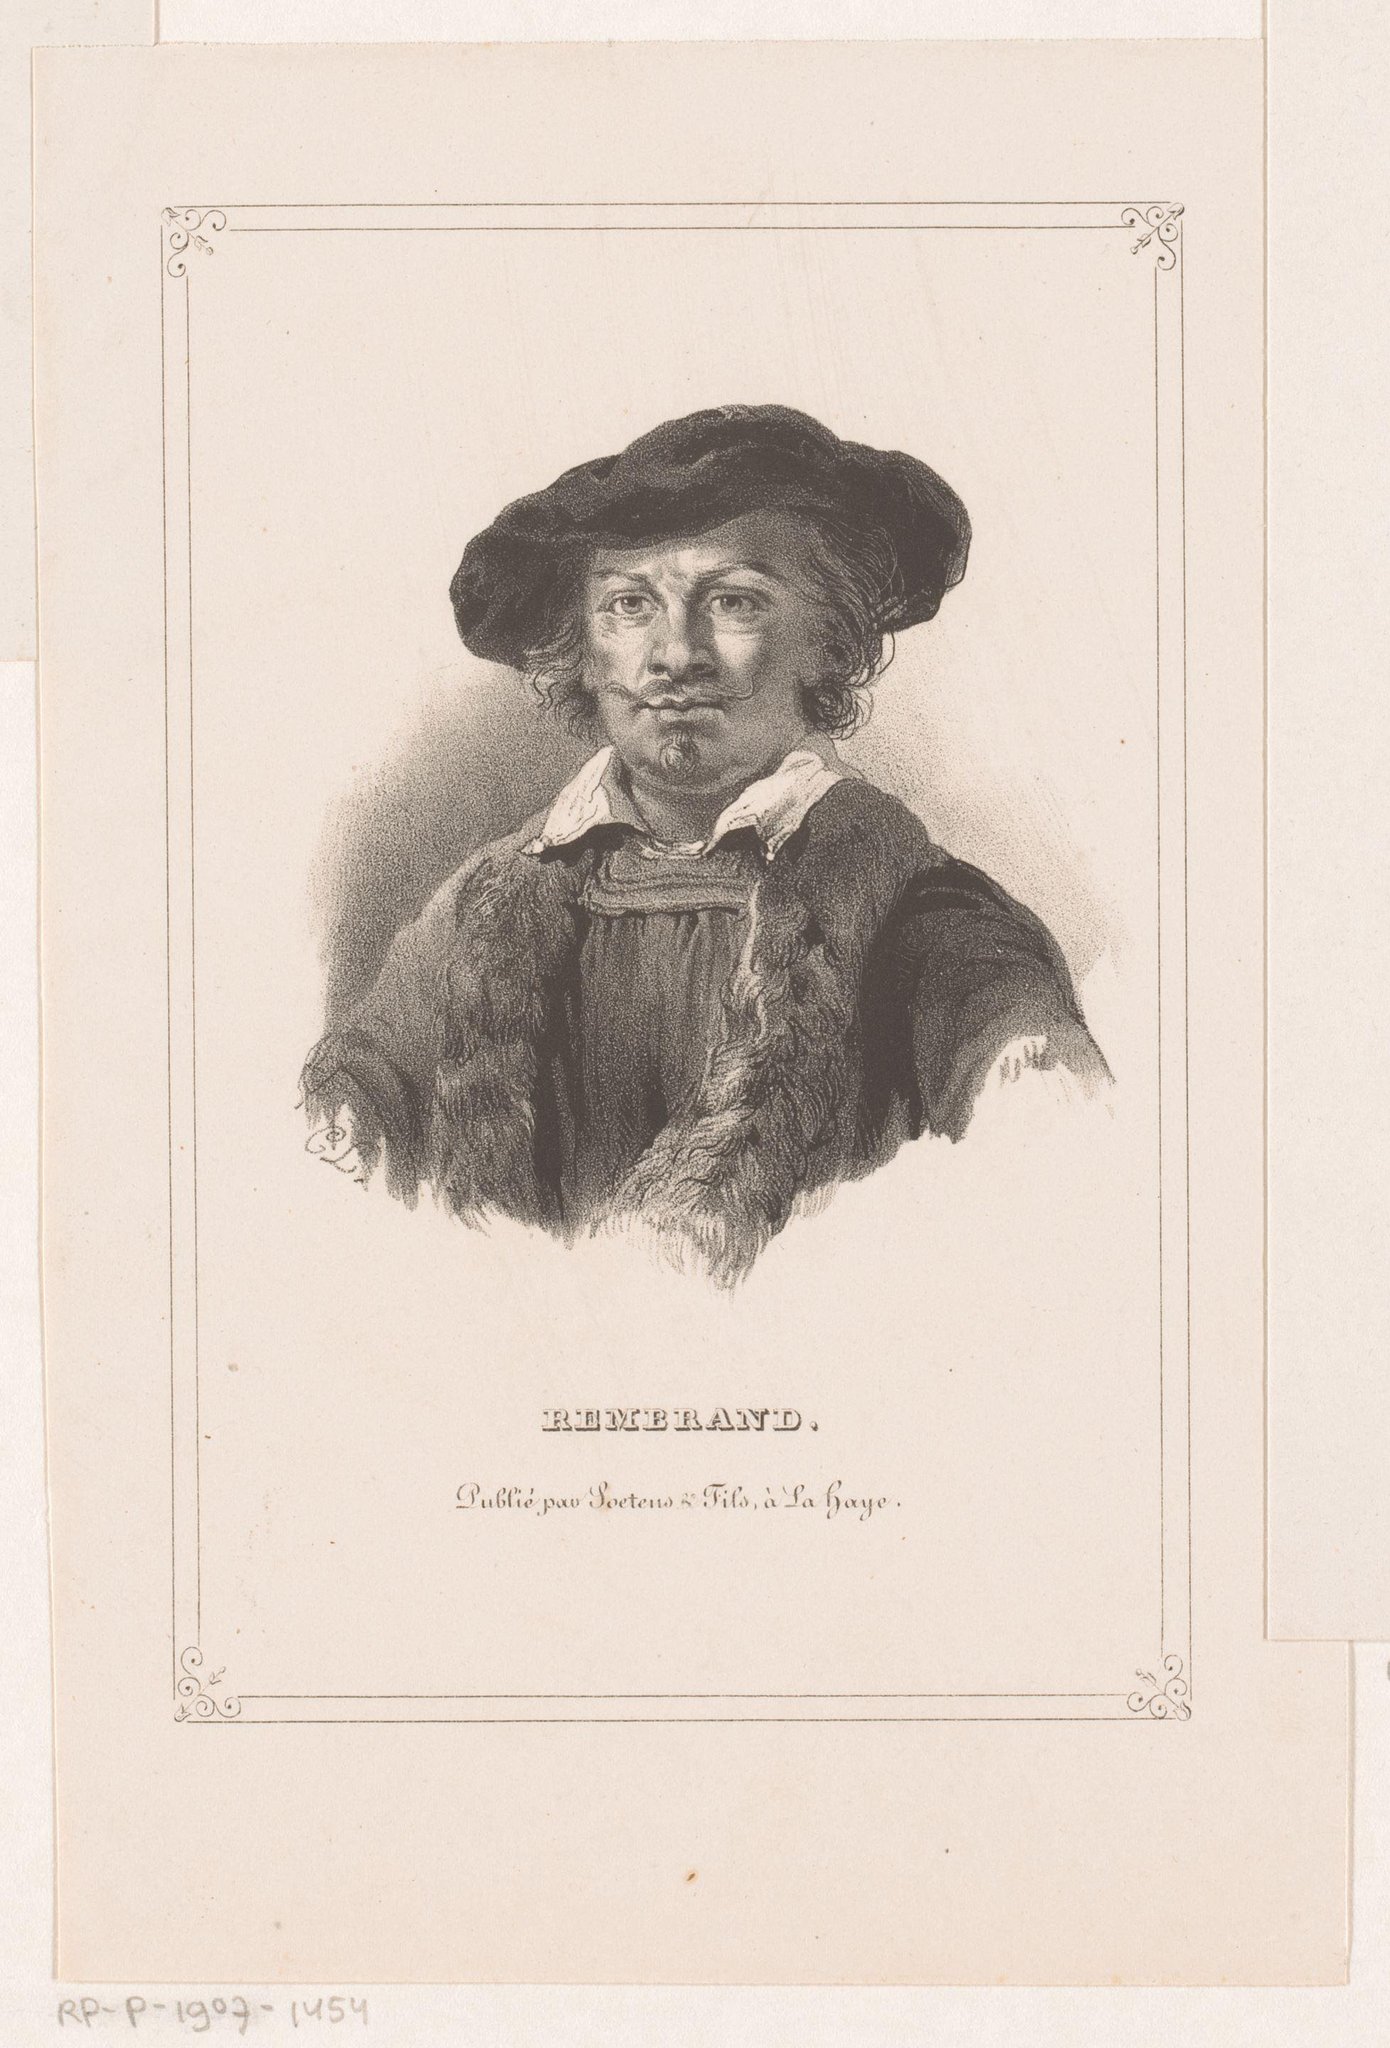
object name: print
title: Portret van Rembrandt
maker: carel christiaan antony last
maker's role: print maker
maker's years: 1808-1876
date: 1837-1840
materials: paper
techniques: lithograph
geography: the hague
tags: leiden, painter, print maker, draughtsman, rembrandt van rijn, head-gear: beret, historical persons (+ (full) bust portrait)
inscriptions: collector's mark: Lugt 2228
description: De geportretteerde draagt een baret en een mantel met een kraag van bont.